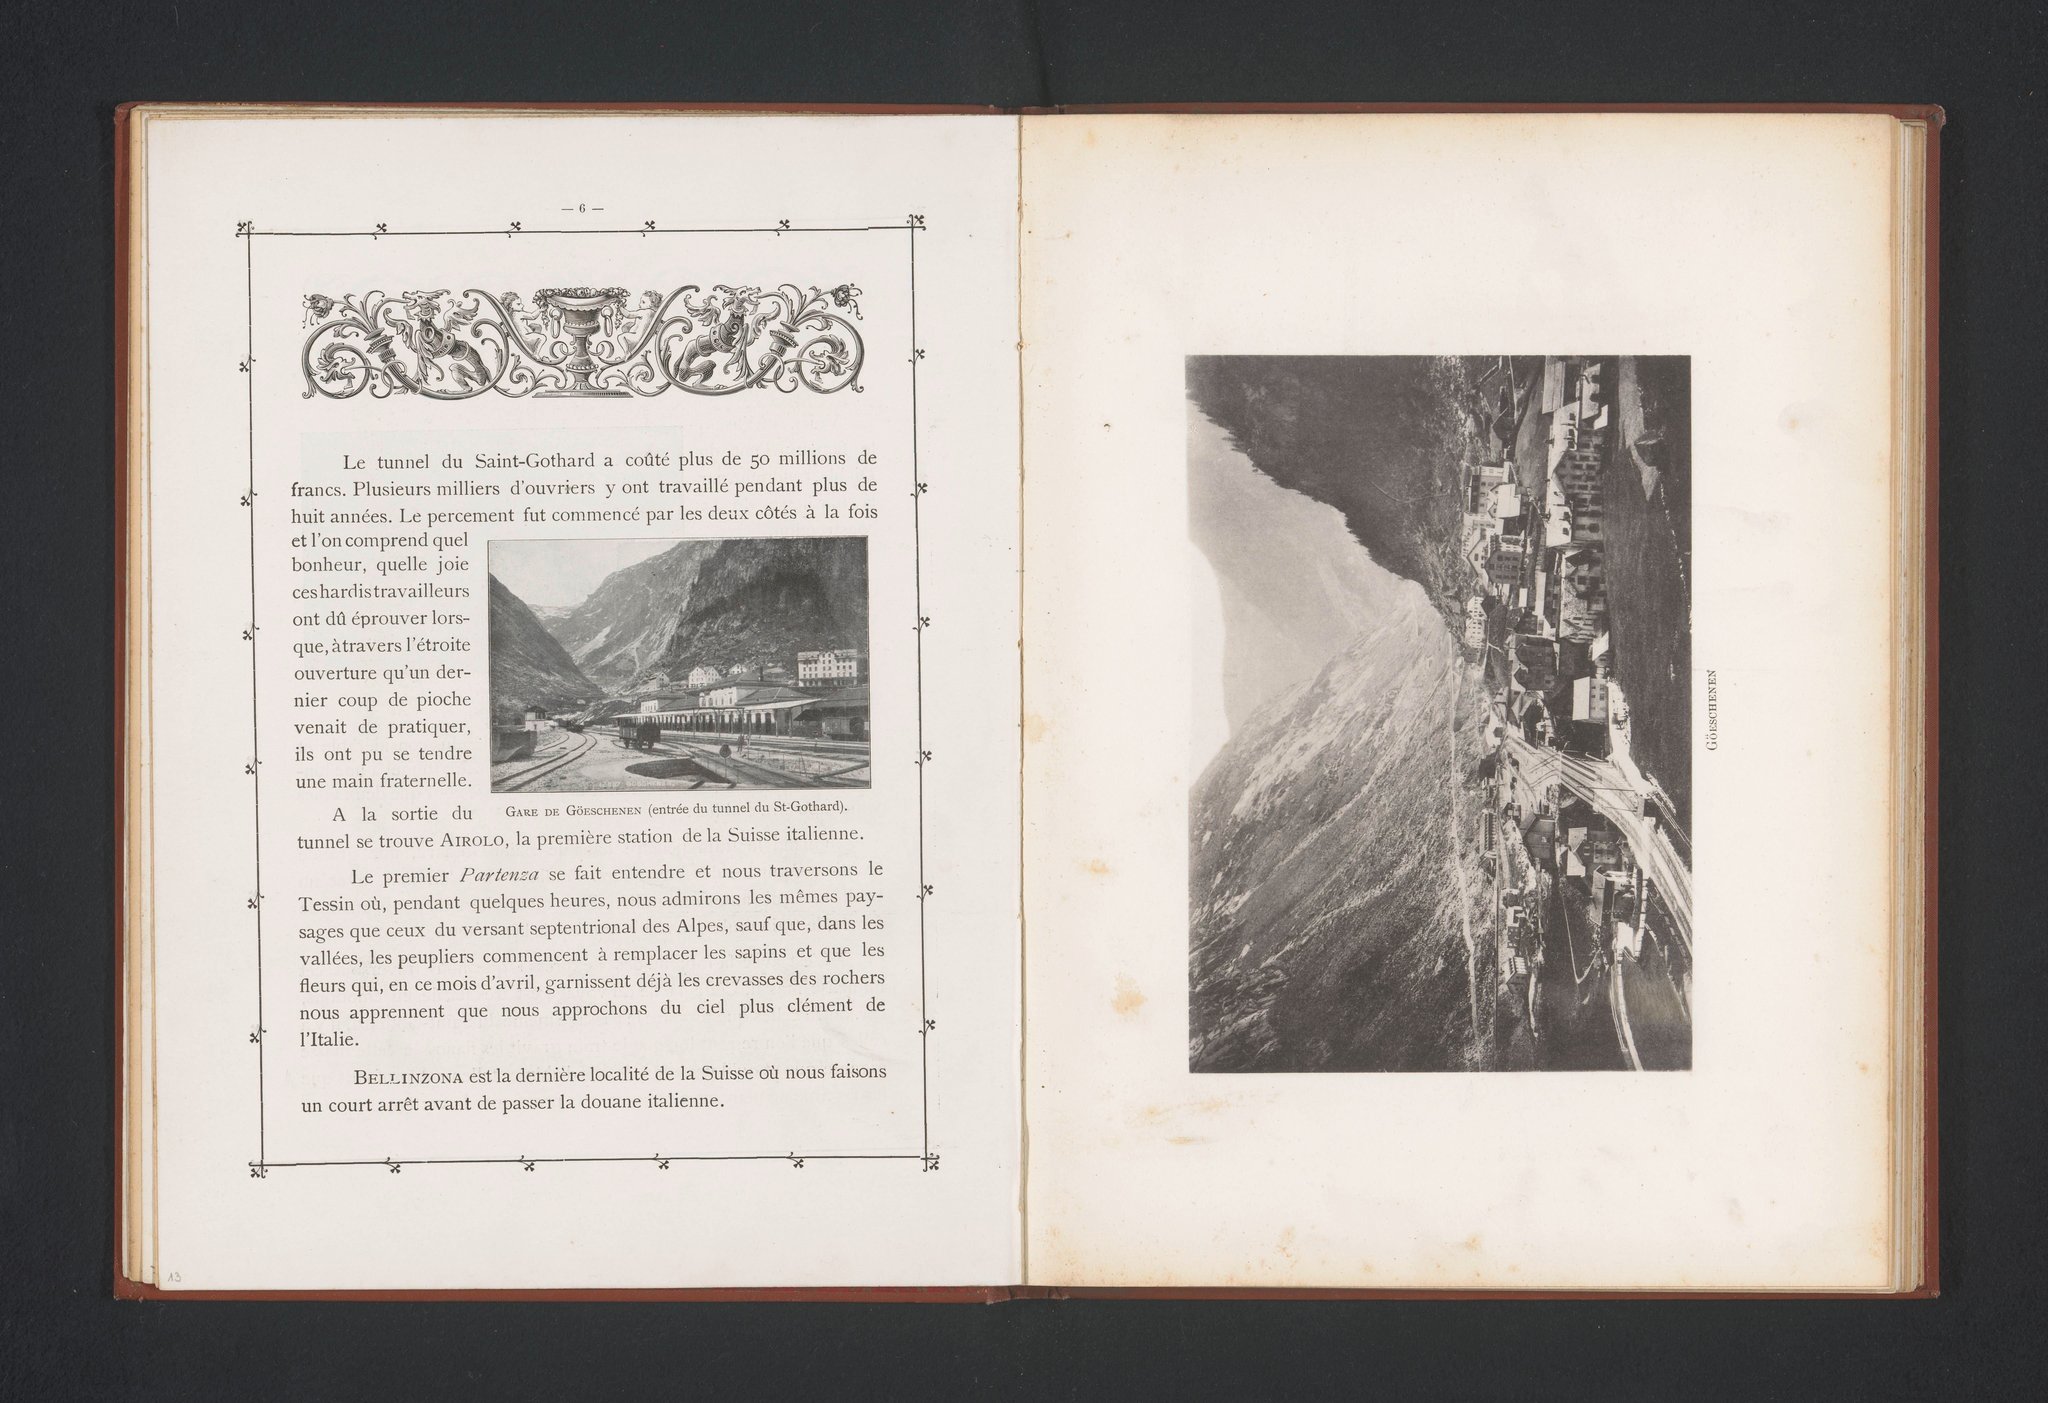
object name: page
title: Gezicht op het treinstation van Göschenen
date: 1893-1898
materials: paper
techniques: autotype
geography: göschenen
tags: station; shelter (railway, tramway), mountains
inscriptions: inscription: ‘13087 GOSCHENEN.’